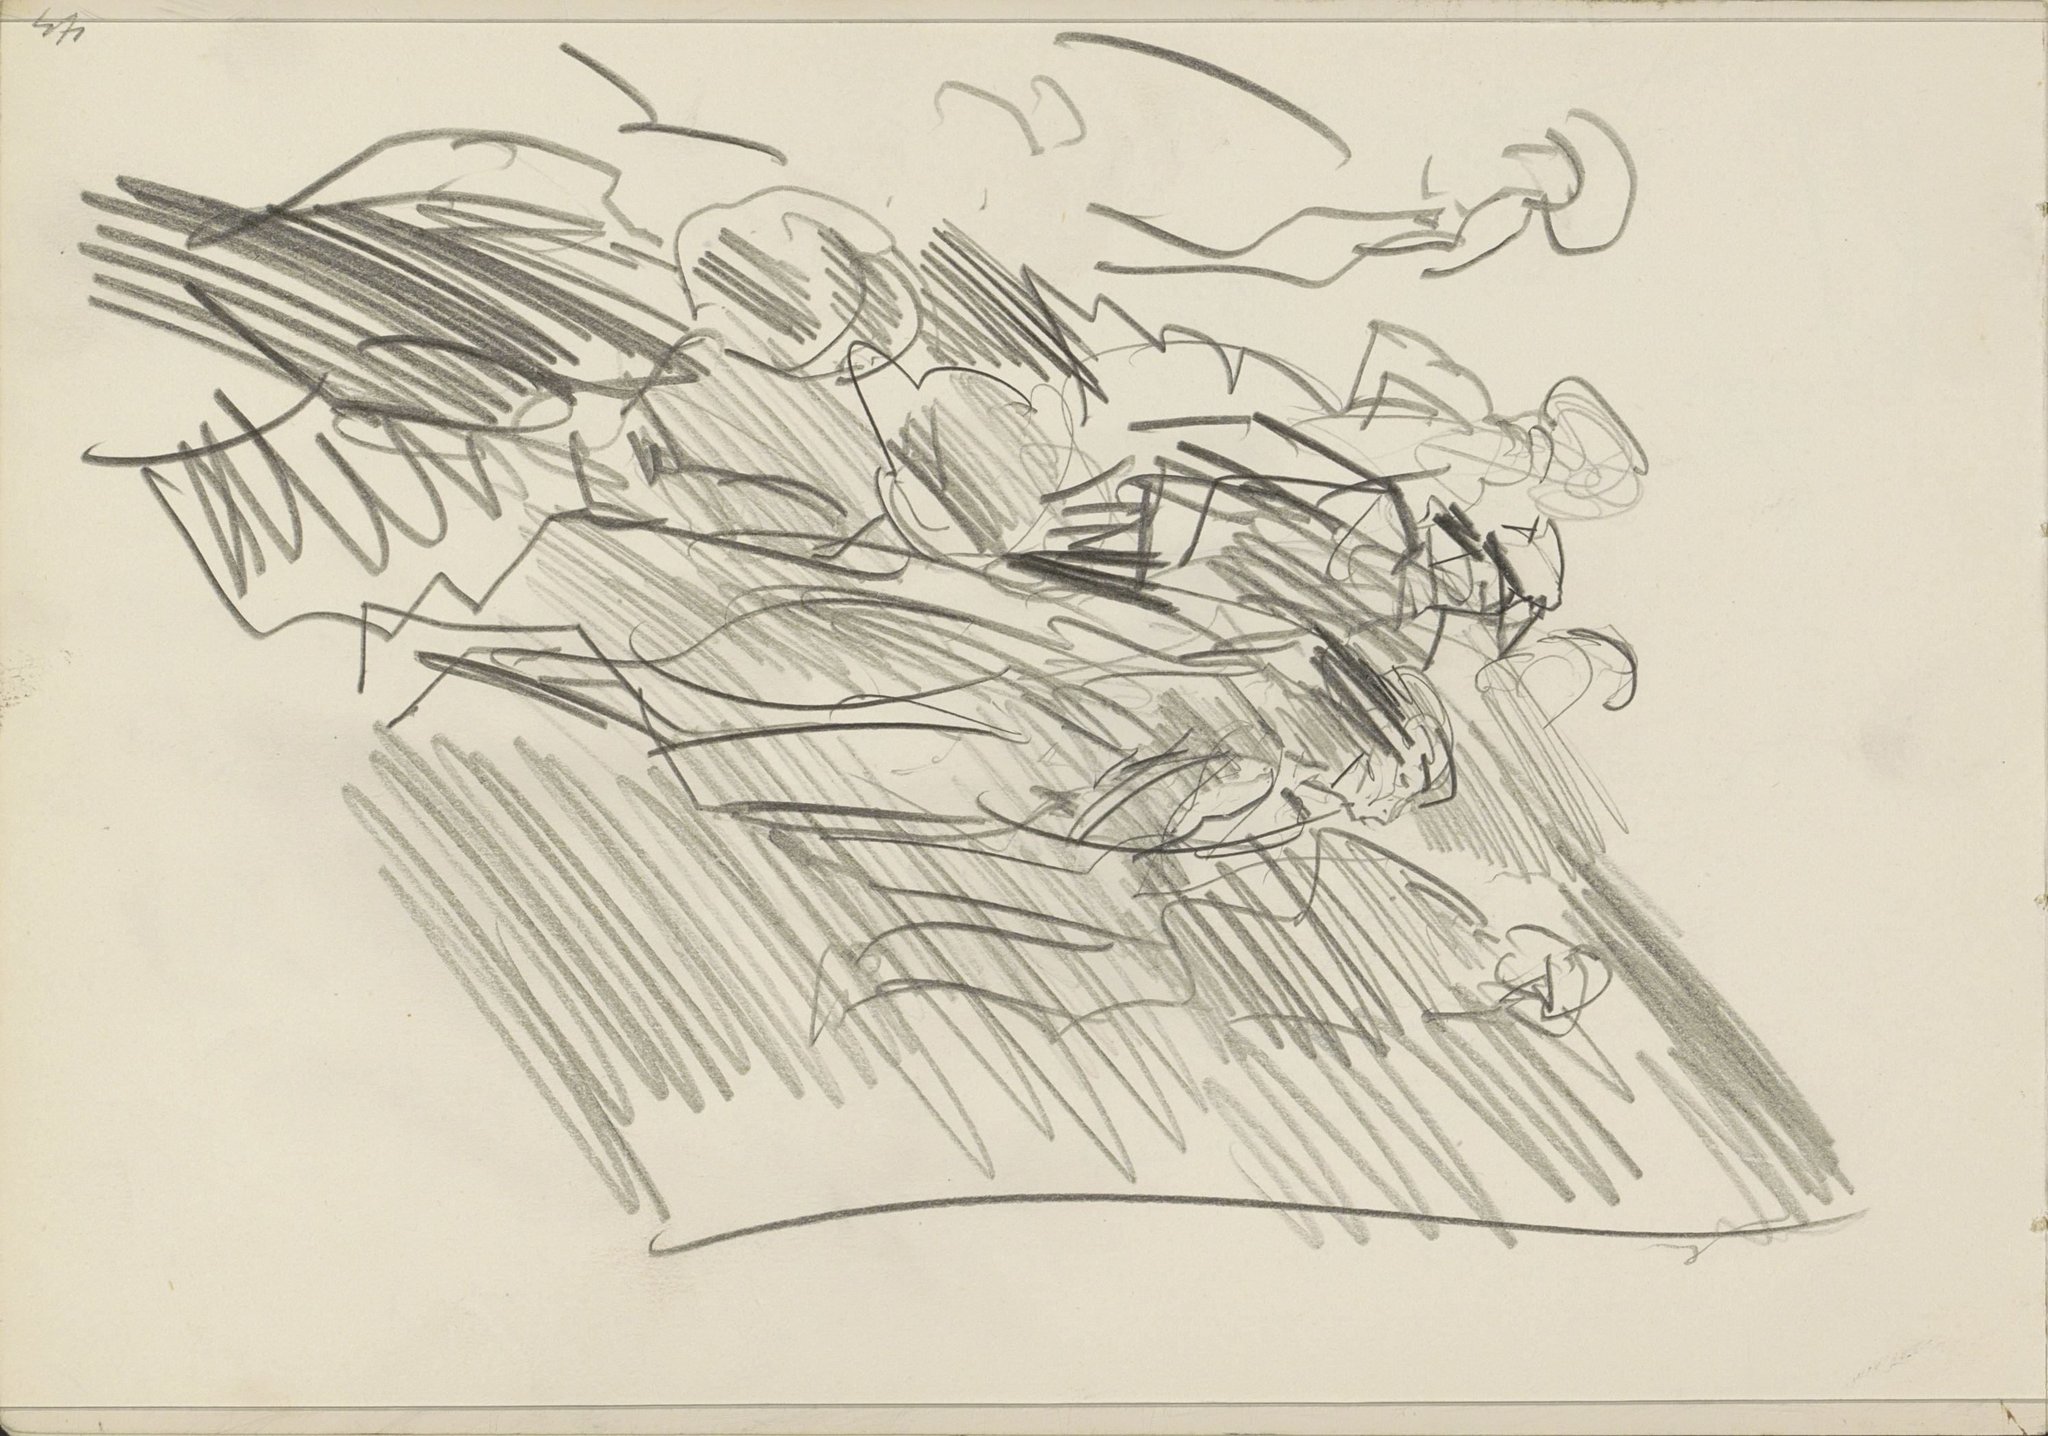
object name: sketchbook leaf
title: Figuurstudies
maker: isaac israels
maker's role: draughtsman, painter, print maker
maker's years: 1865-1934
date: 1915-1934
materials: paper, pencil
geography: the hague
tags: adult woman (+ standing), adult man (+ standing)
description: Blad 4 verso uit schetsboek XXV met 23 bladen.